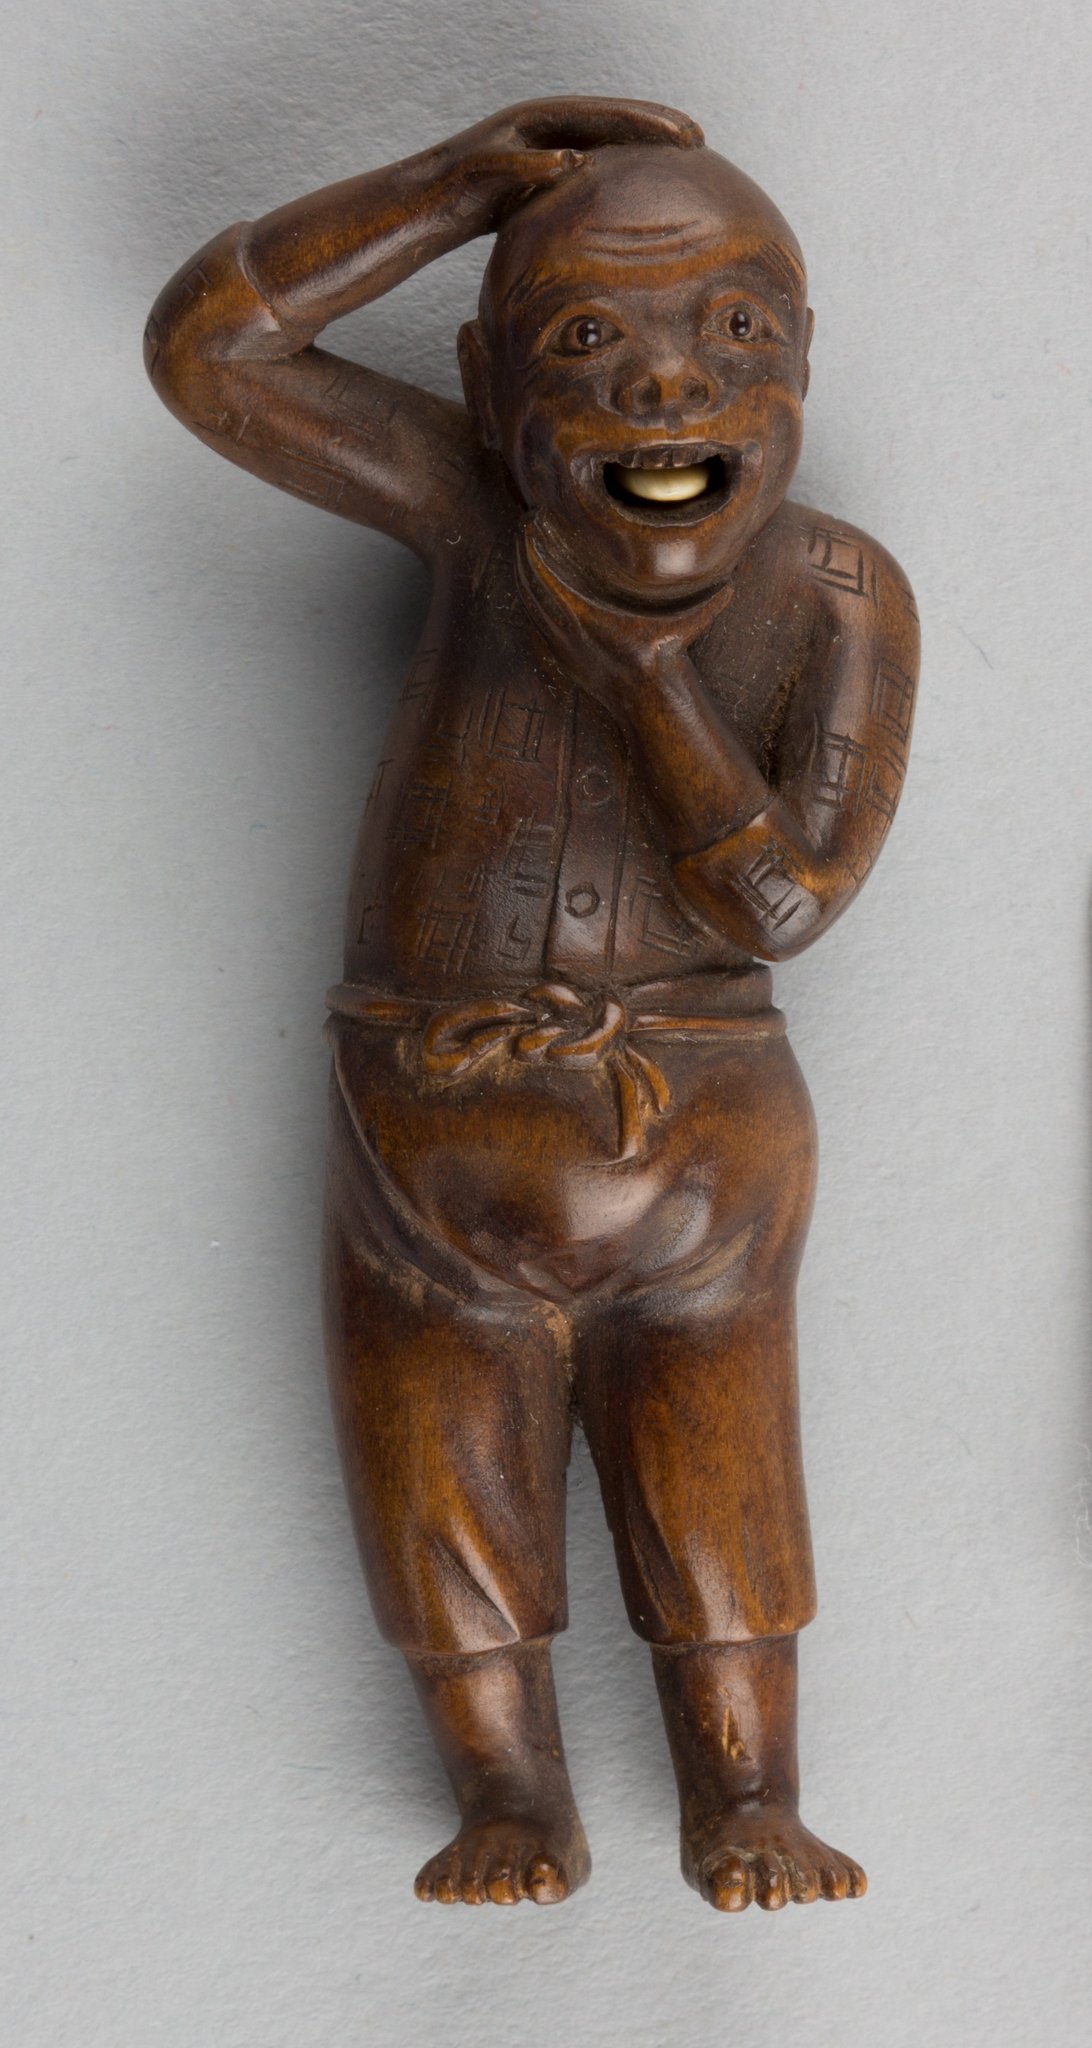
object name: netsuke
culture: japanese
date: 1701-1800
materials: wood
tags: men